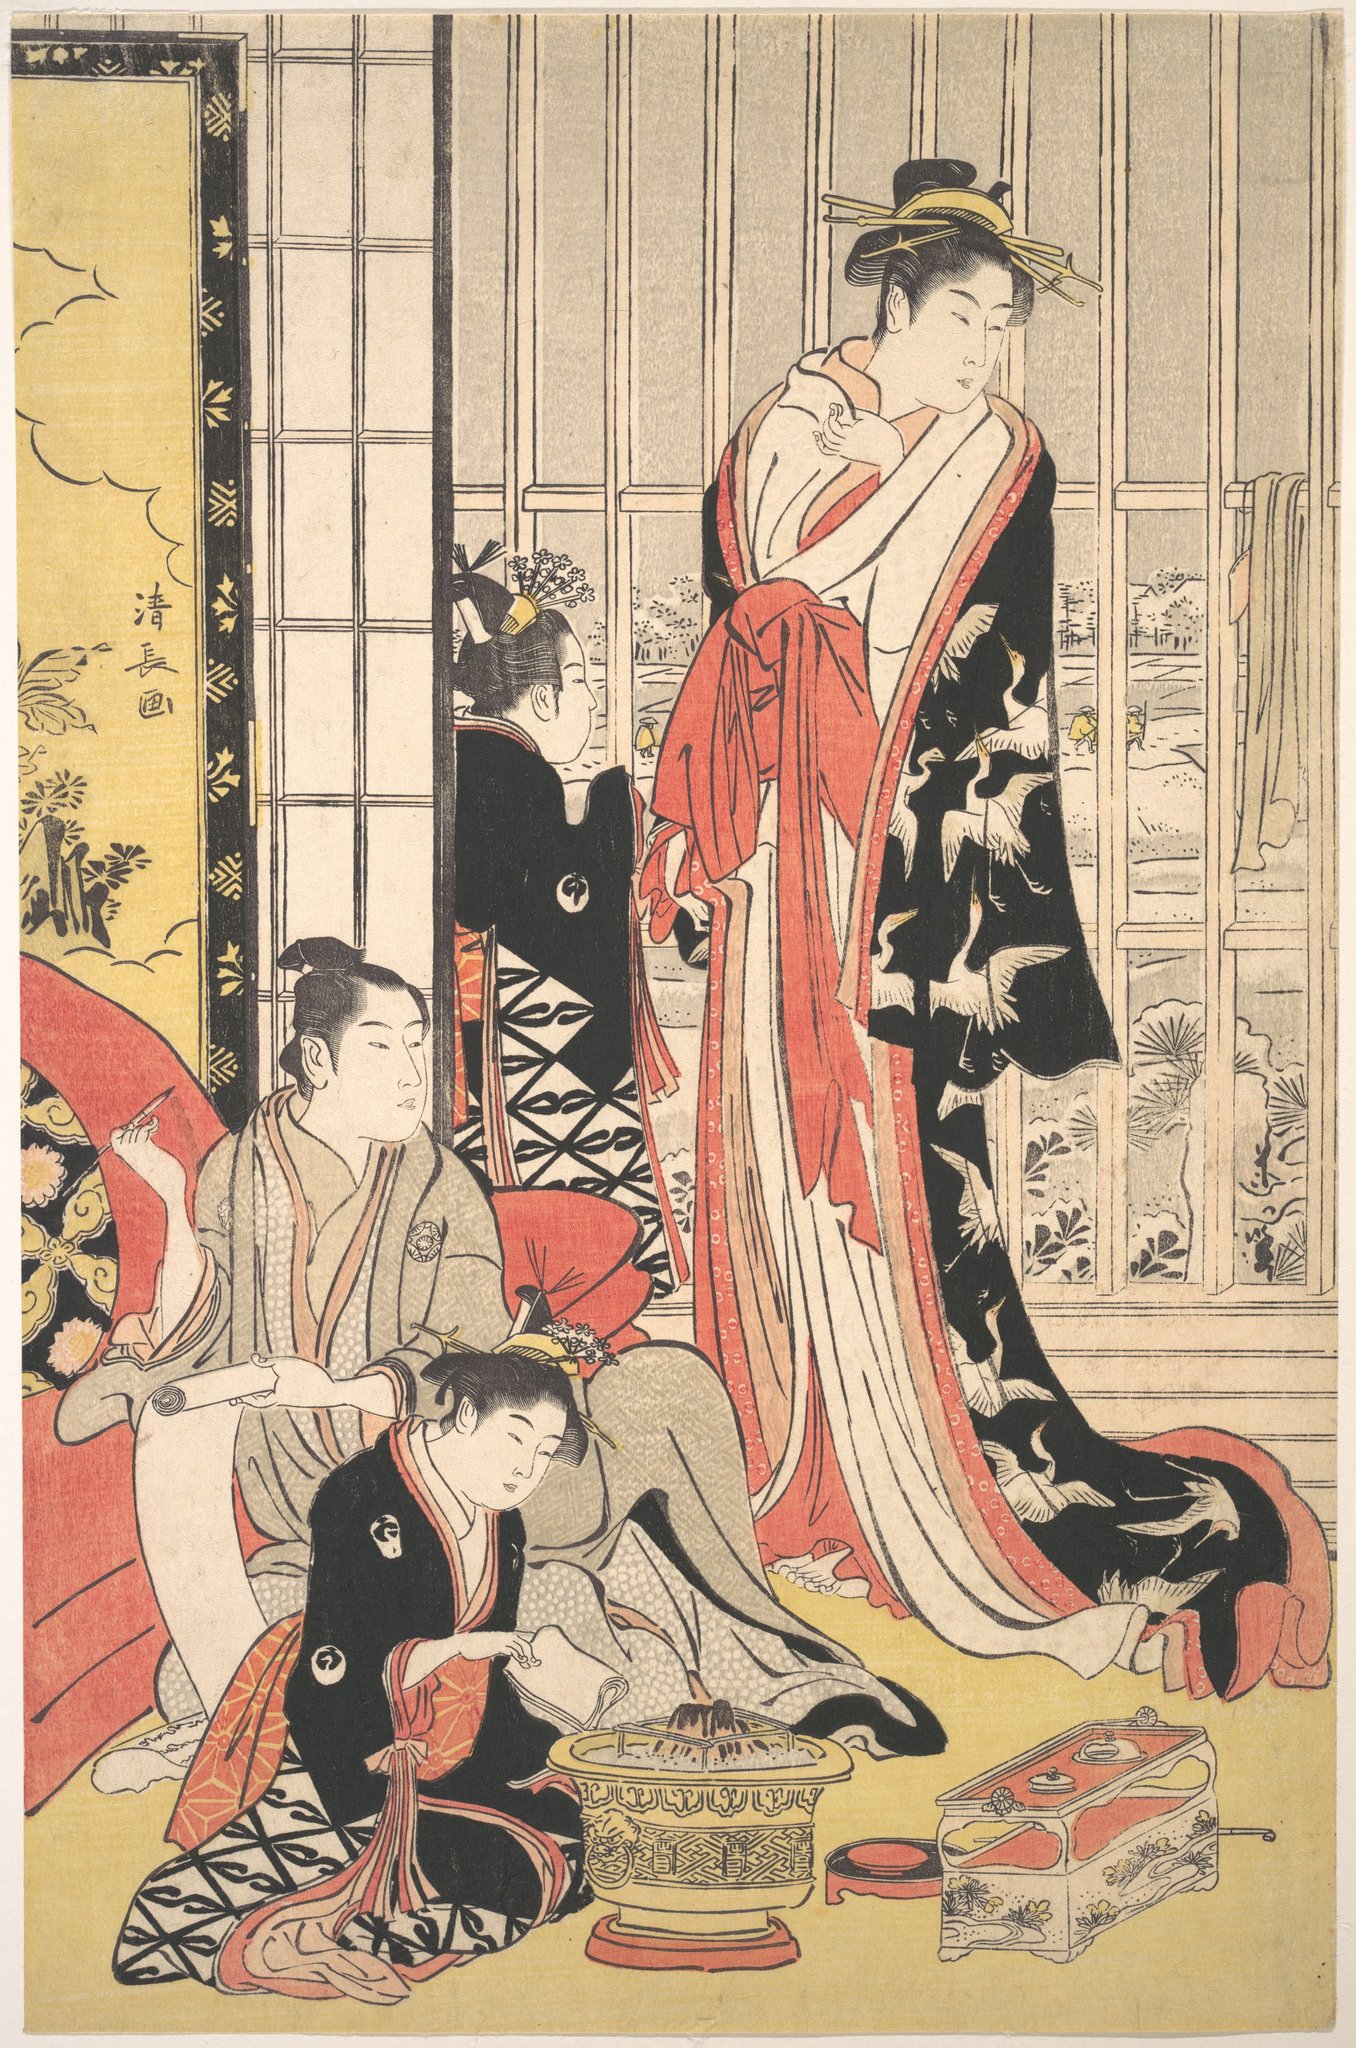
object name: print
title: Interior Scene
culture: japanese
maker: torii kiyonaga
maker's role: artist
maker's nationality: japanese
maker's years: 1752-1815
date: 1788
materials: ink, paper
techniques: woodblock print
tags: interiors,women